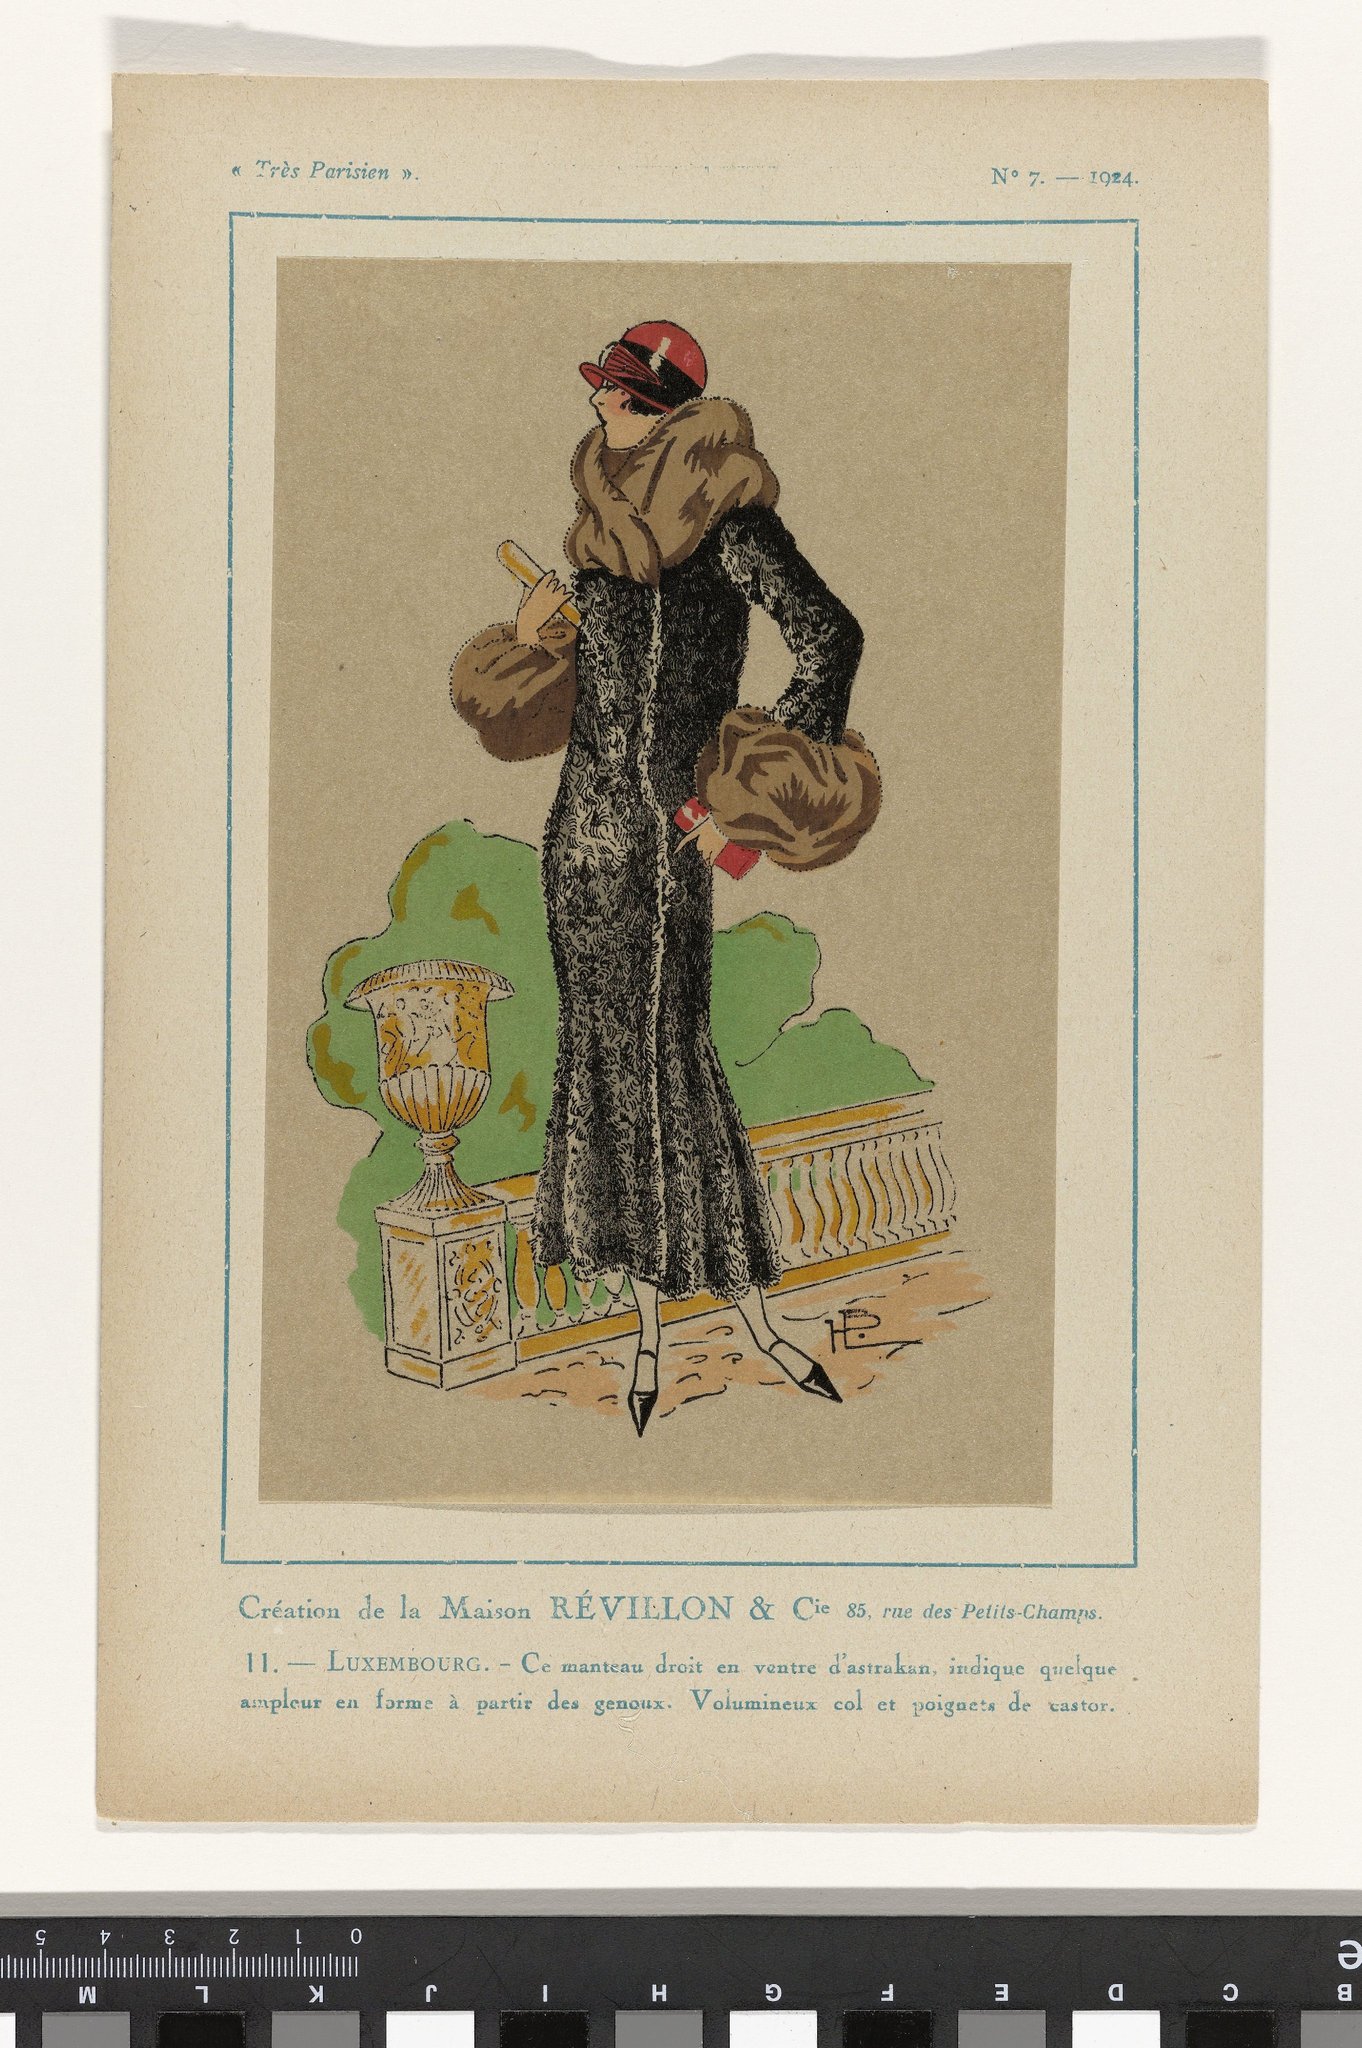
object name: fashion print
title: Très Parisien, 1924, No. 7 : Création de la Maison RÉVILLON & Ci (...)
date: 1924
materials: paper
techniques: hand coloring, letterpress printing, lithography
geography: paris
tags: coat (+ fur used for clothes), coat (+ women's clothes), fashion plates, neck-gear: collar (+ fur used for clothes)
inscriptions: caption: ‘Création de la Maison RÉVILLON & Cie 85, rue des Petits-Champs. / 11. - LUXEMBOURG. - Ce manteau droit en ventre d'astrakan, indique quelque ampleur en forme à partir des genoux. Volumineux col et poignets de castor.’, title: ‘" Très Parisien" / No 7. - 1924’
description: Ontwerp van Maison Révillon & Cie. Mantel, recht model, van astrakan. Grote kraag en manchetten van castor. Accessoires: cloche (pothoed), handtas (?), schoenen met puntige neuzen. Prent uit het modetijdschrift Très Parisien (1920-1936).